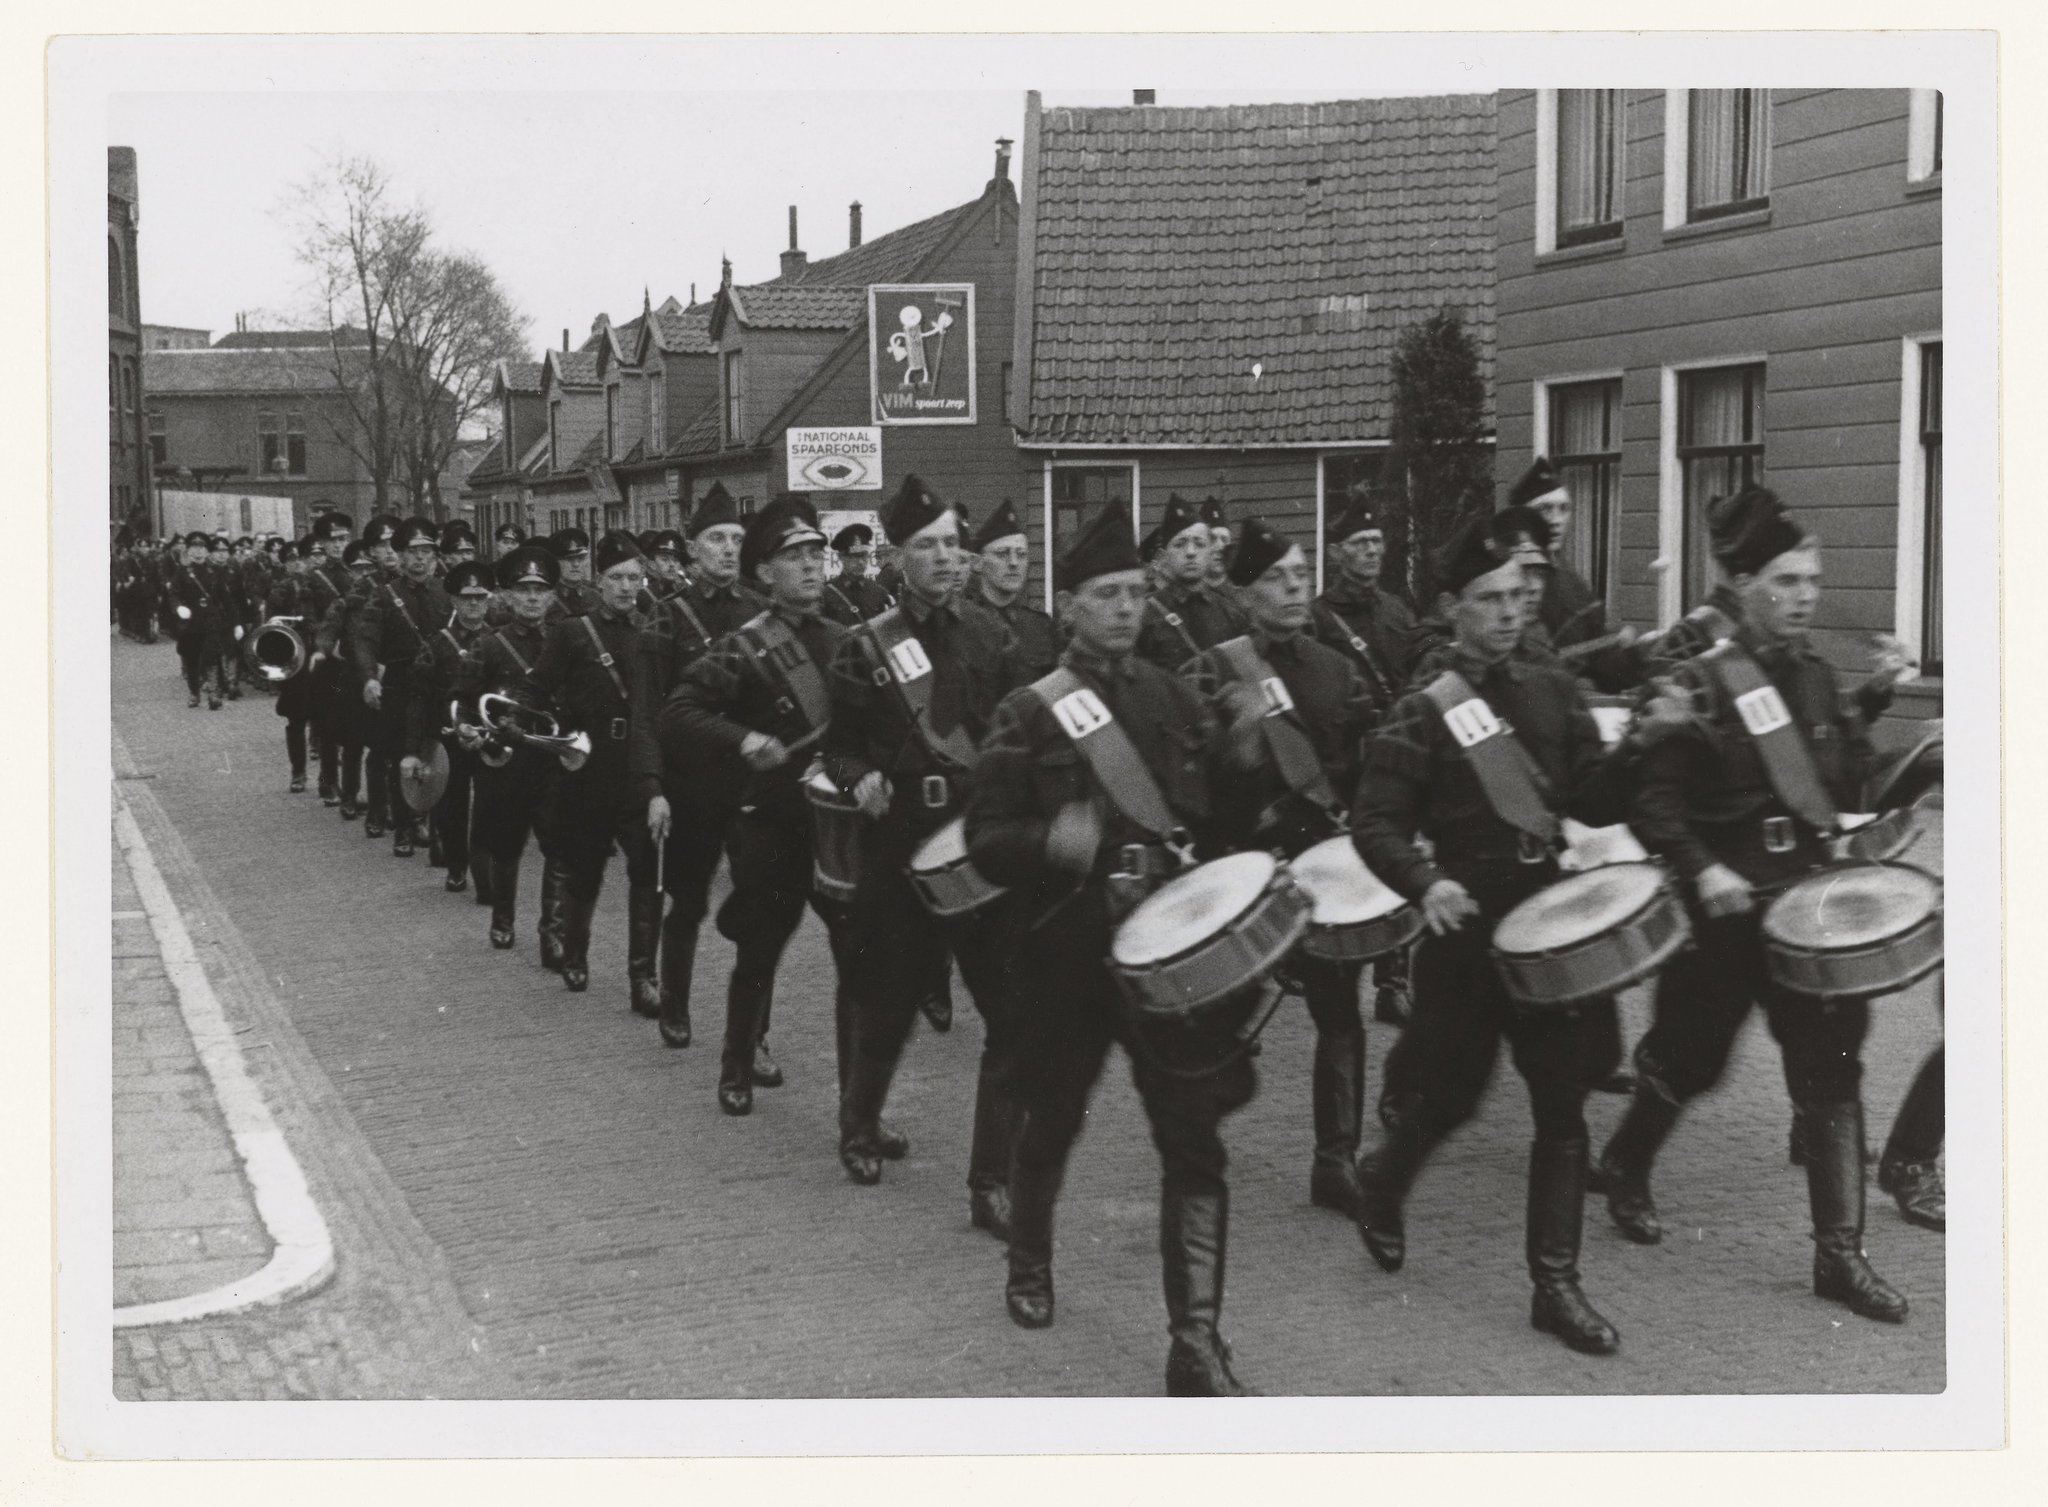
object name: photograph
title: Optocht van de WA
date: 1940-1943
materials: photographic support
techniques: gelatin silver print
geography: netherlands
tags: military parade, pageant, netherlands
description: Optocht van de WA met trommels en blaasinstrumenten.